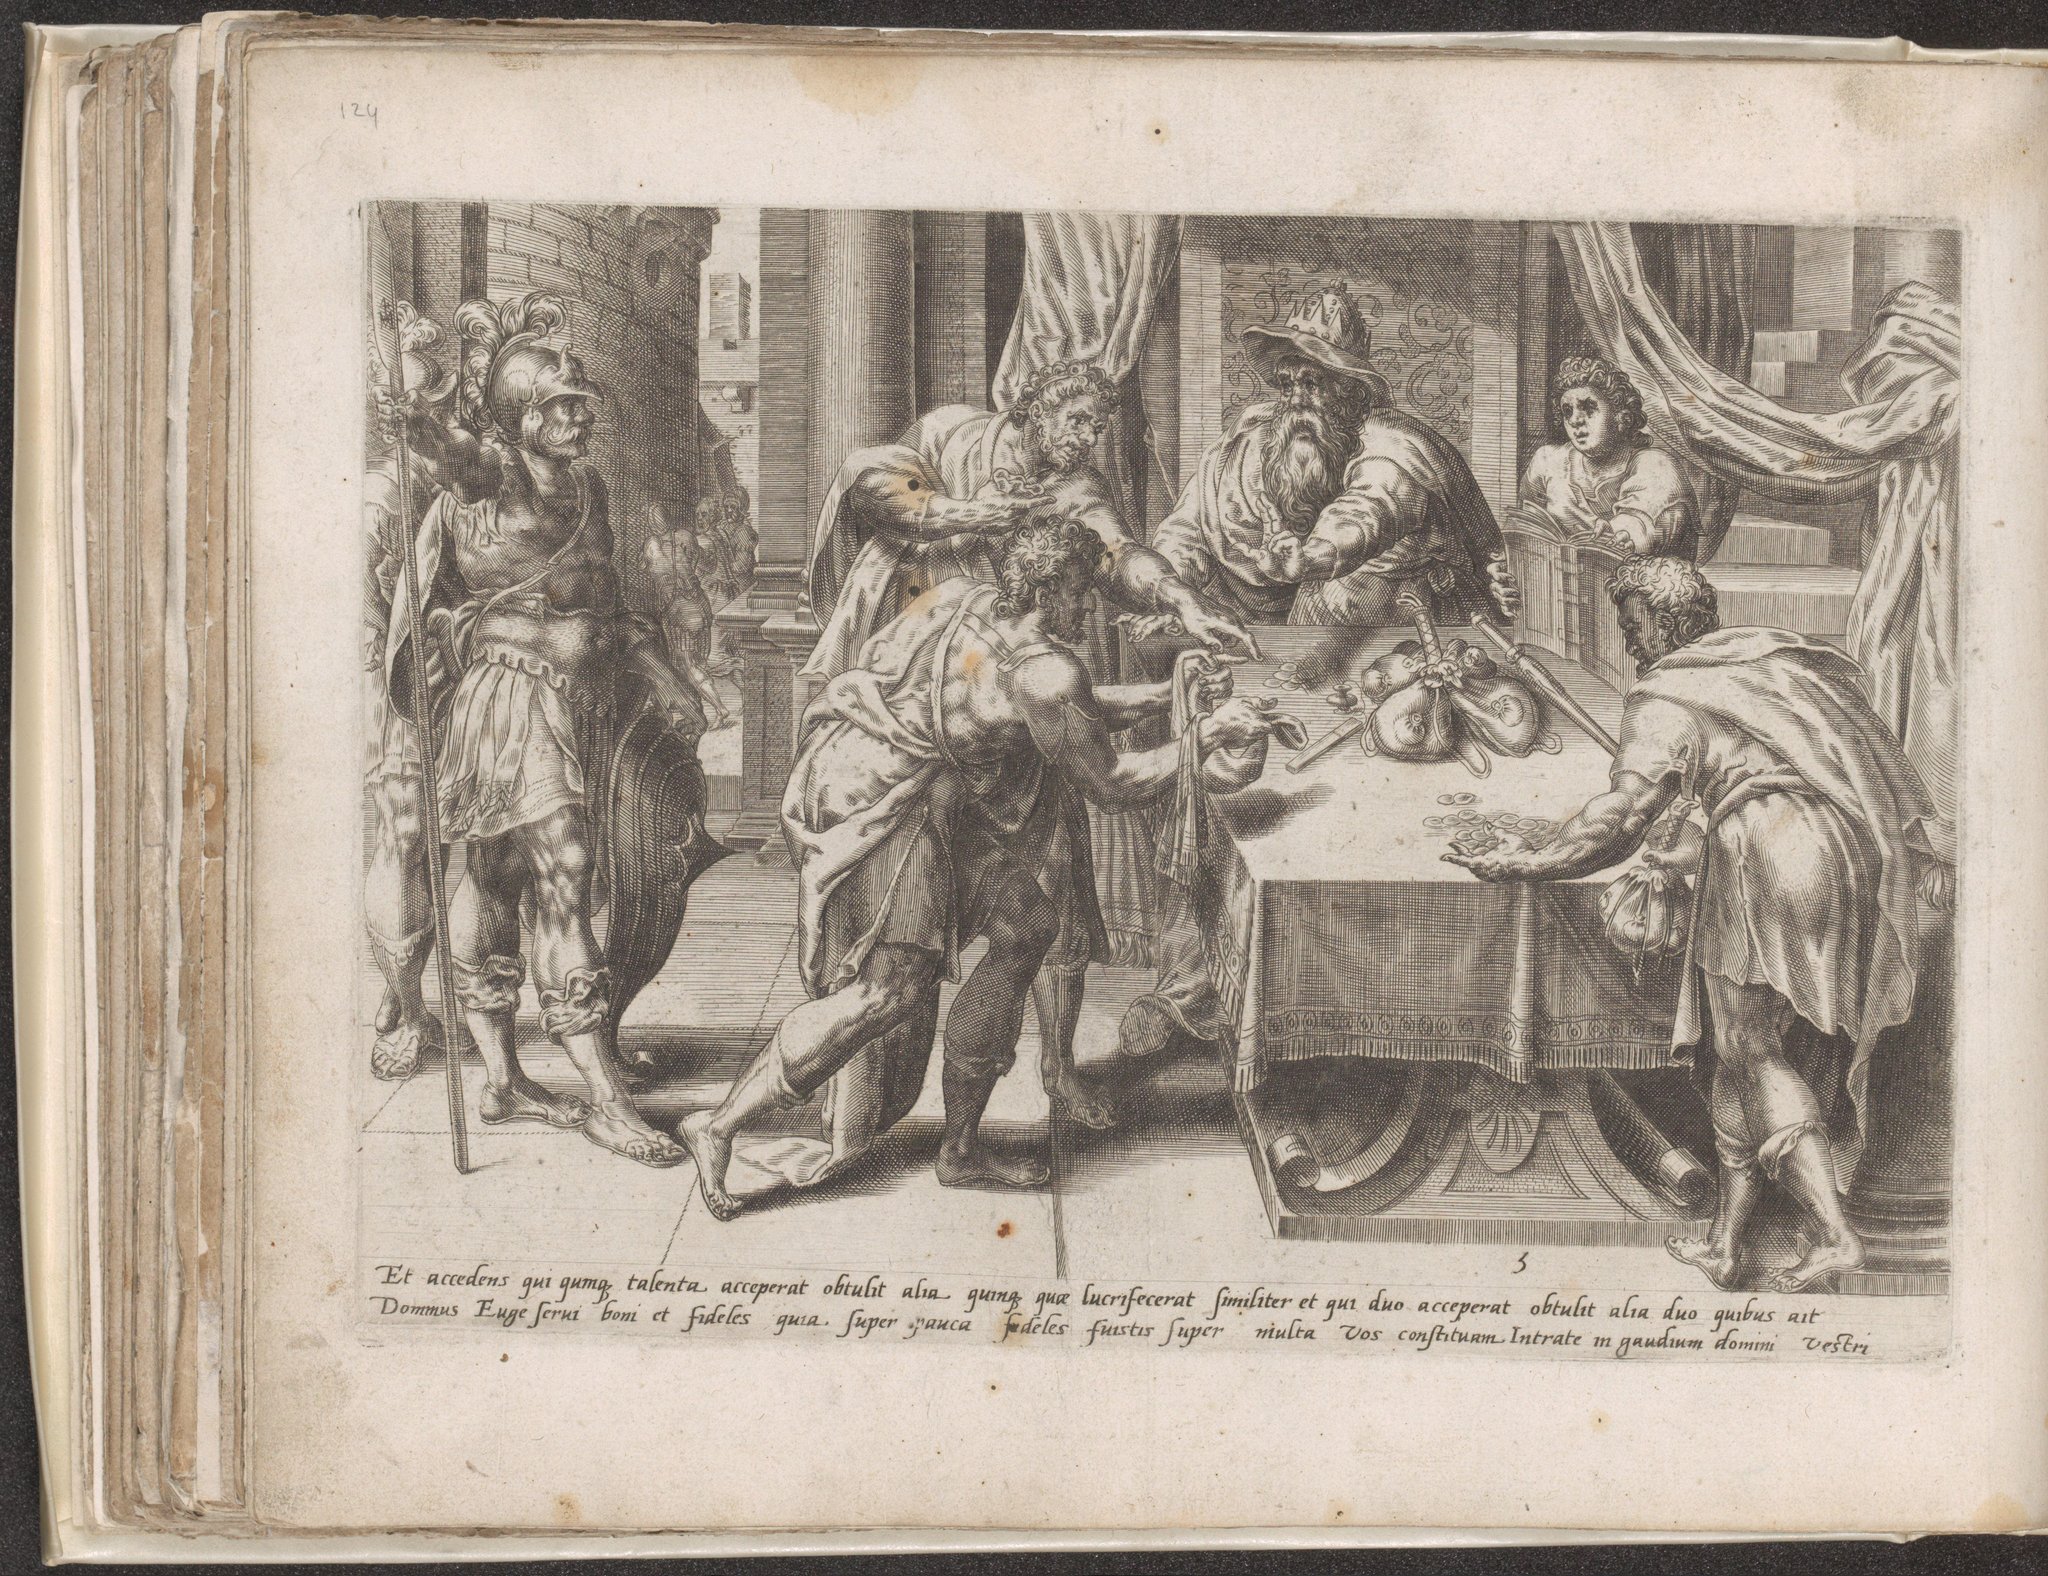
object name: album leaf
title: Heer vraagt zijn dienaren om rekenschap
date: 1565-1572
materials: paper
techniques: engraving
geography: antwerp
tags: after the return of the lord the servants account for their debts and are rewarded accordingly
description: De heer vraagt zijn drie dienaren om rekenschap. Degenen met vijf talenten en twee talenten hebben allebei hetzelfde bedrag erbij verdiend. De laatste dienaar legt zijn bundel met een talent op tafel en geeft de heer precies hetzelfde terug als wat hij gekregen had. Onder de voorstelling een verwijzing in het Latijn naar de Bijbeltekst. Deze prent maakt deel uit van een album.